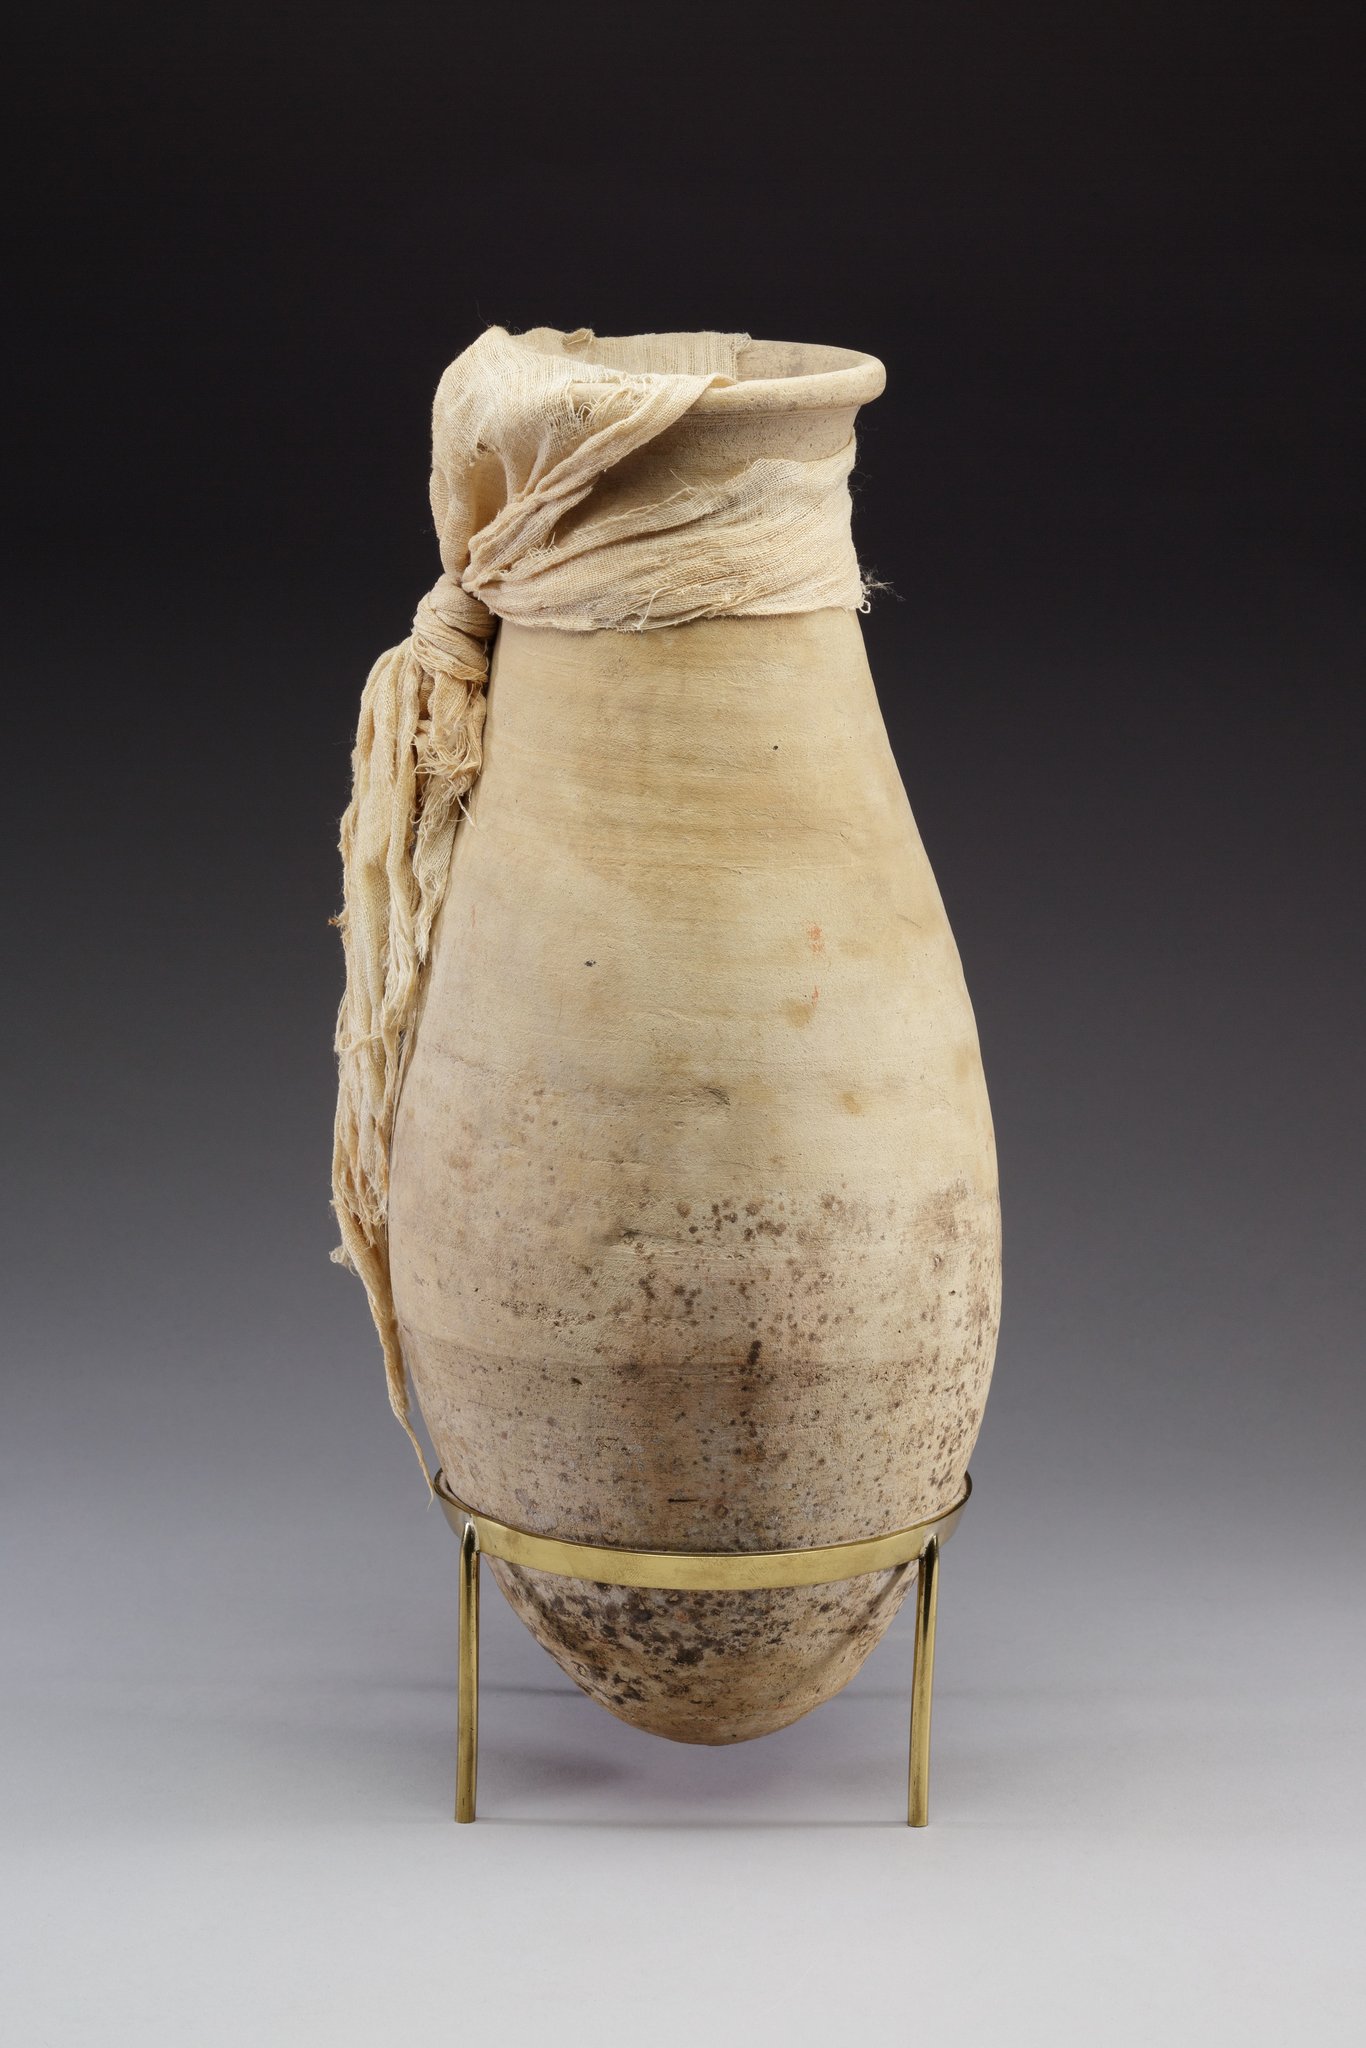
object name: jar, marl, amenhotep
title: Jar from the Burial of Amenhotep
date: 1479-1458 BCE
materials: linen, pottery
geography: egypt